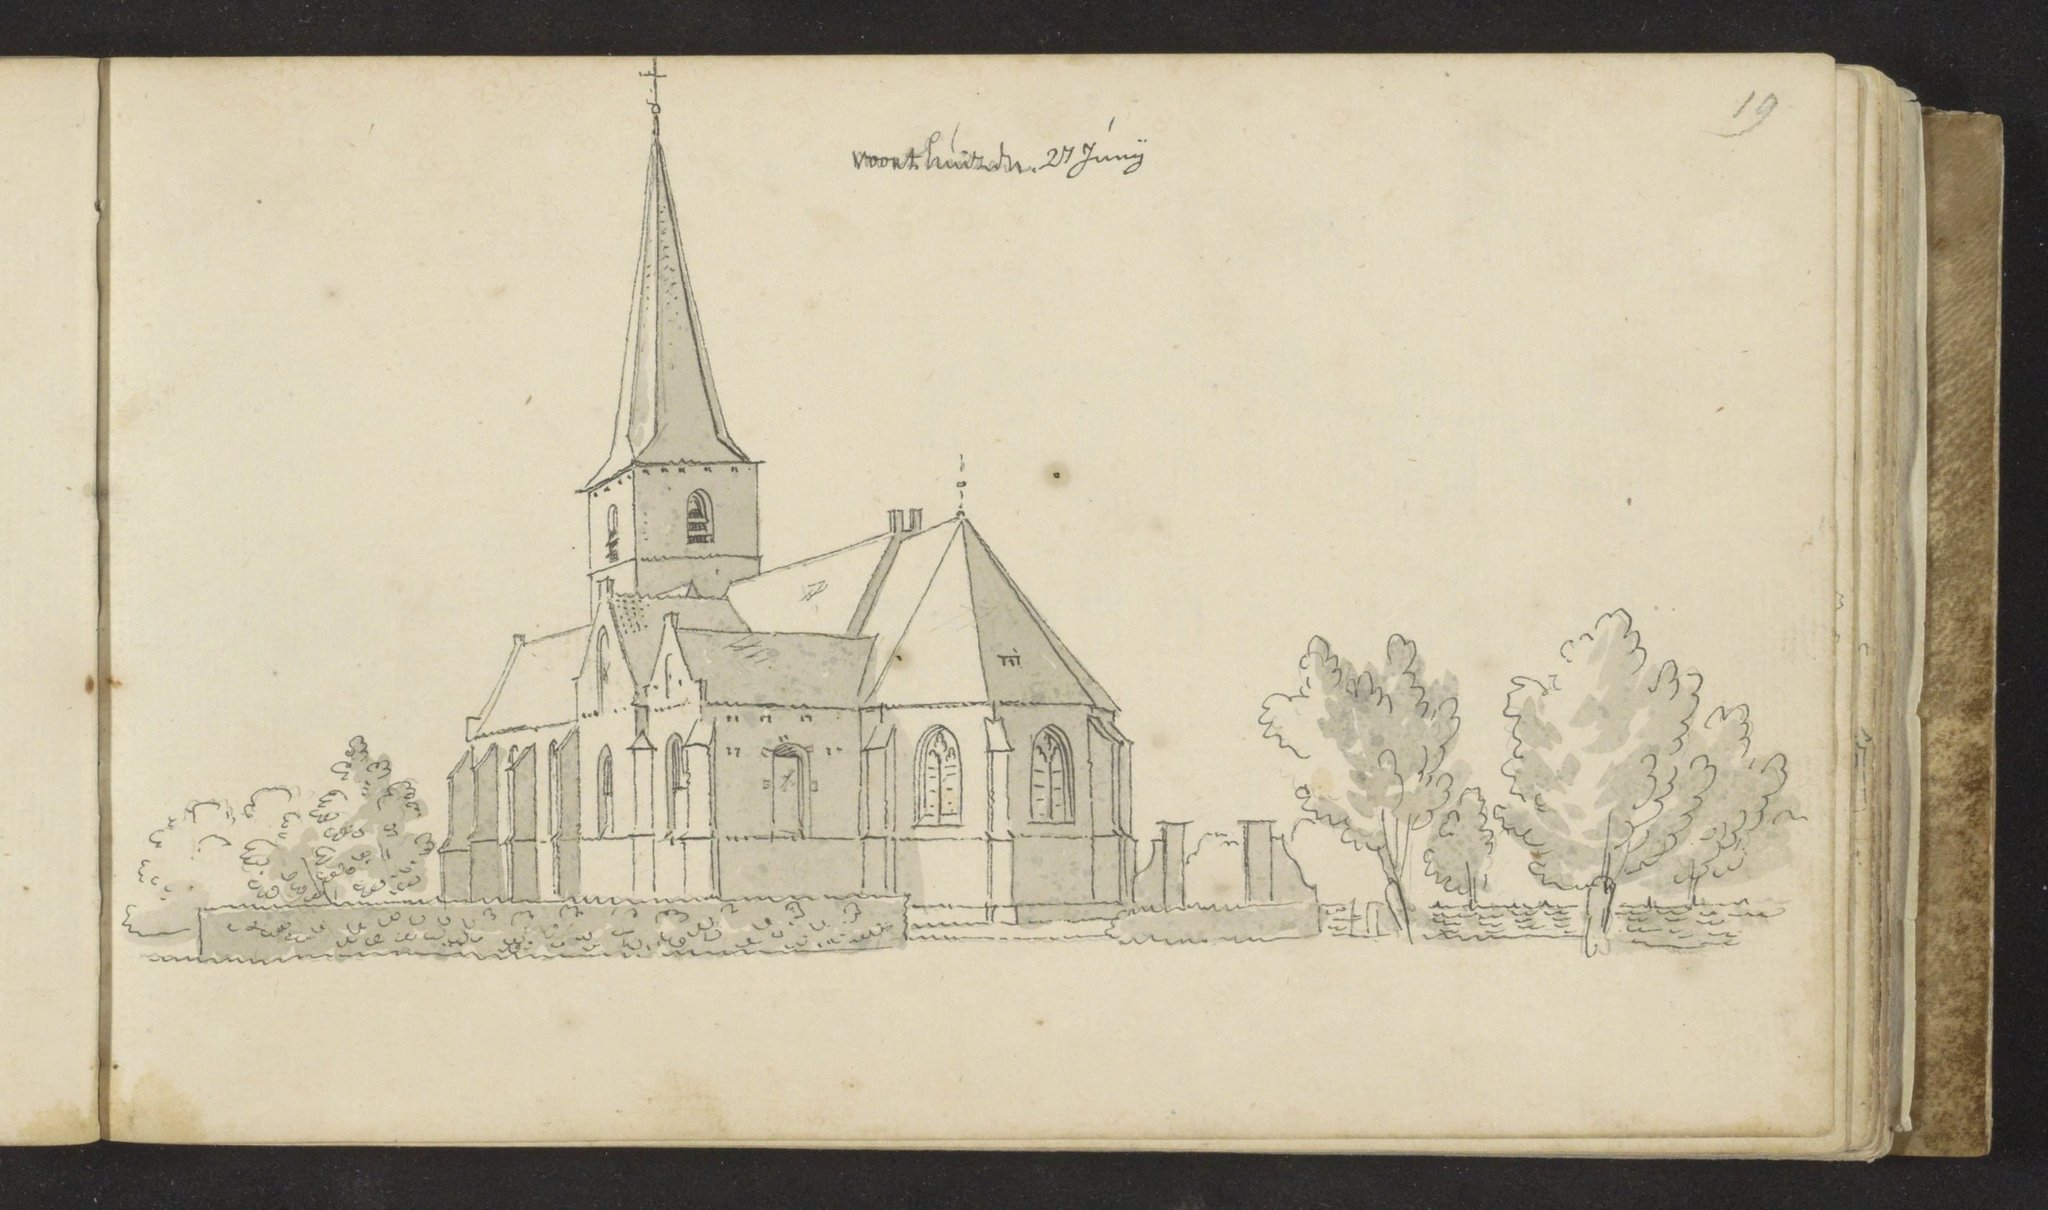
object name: sketchbook leaf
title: Kerk te Voorthuizen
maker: abraham de haen (ii)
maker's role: draughtsman, print maker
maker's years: 1707-1748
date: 1732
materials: ink, paper, pencil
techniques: brush, pen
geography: voorthuizen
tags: church (exterior)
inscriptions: annotation: ‘voorthuizen.27junij’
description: Blad 19 recto uit een schetsboek met 51 bladen.